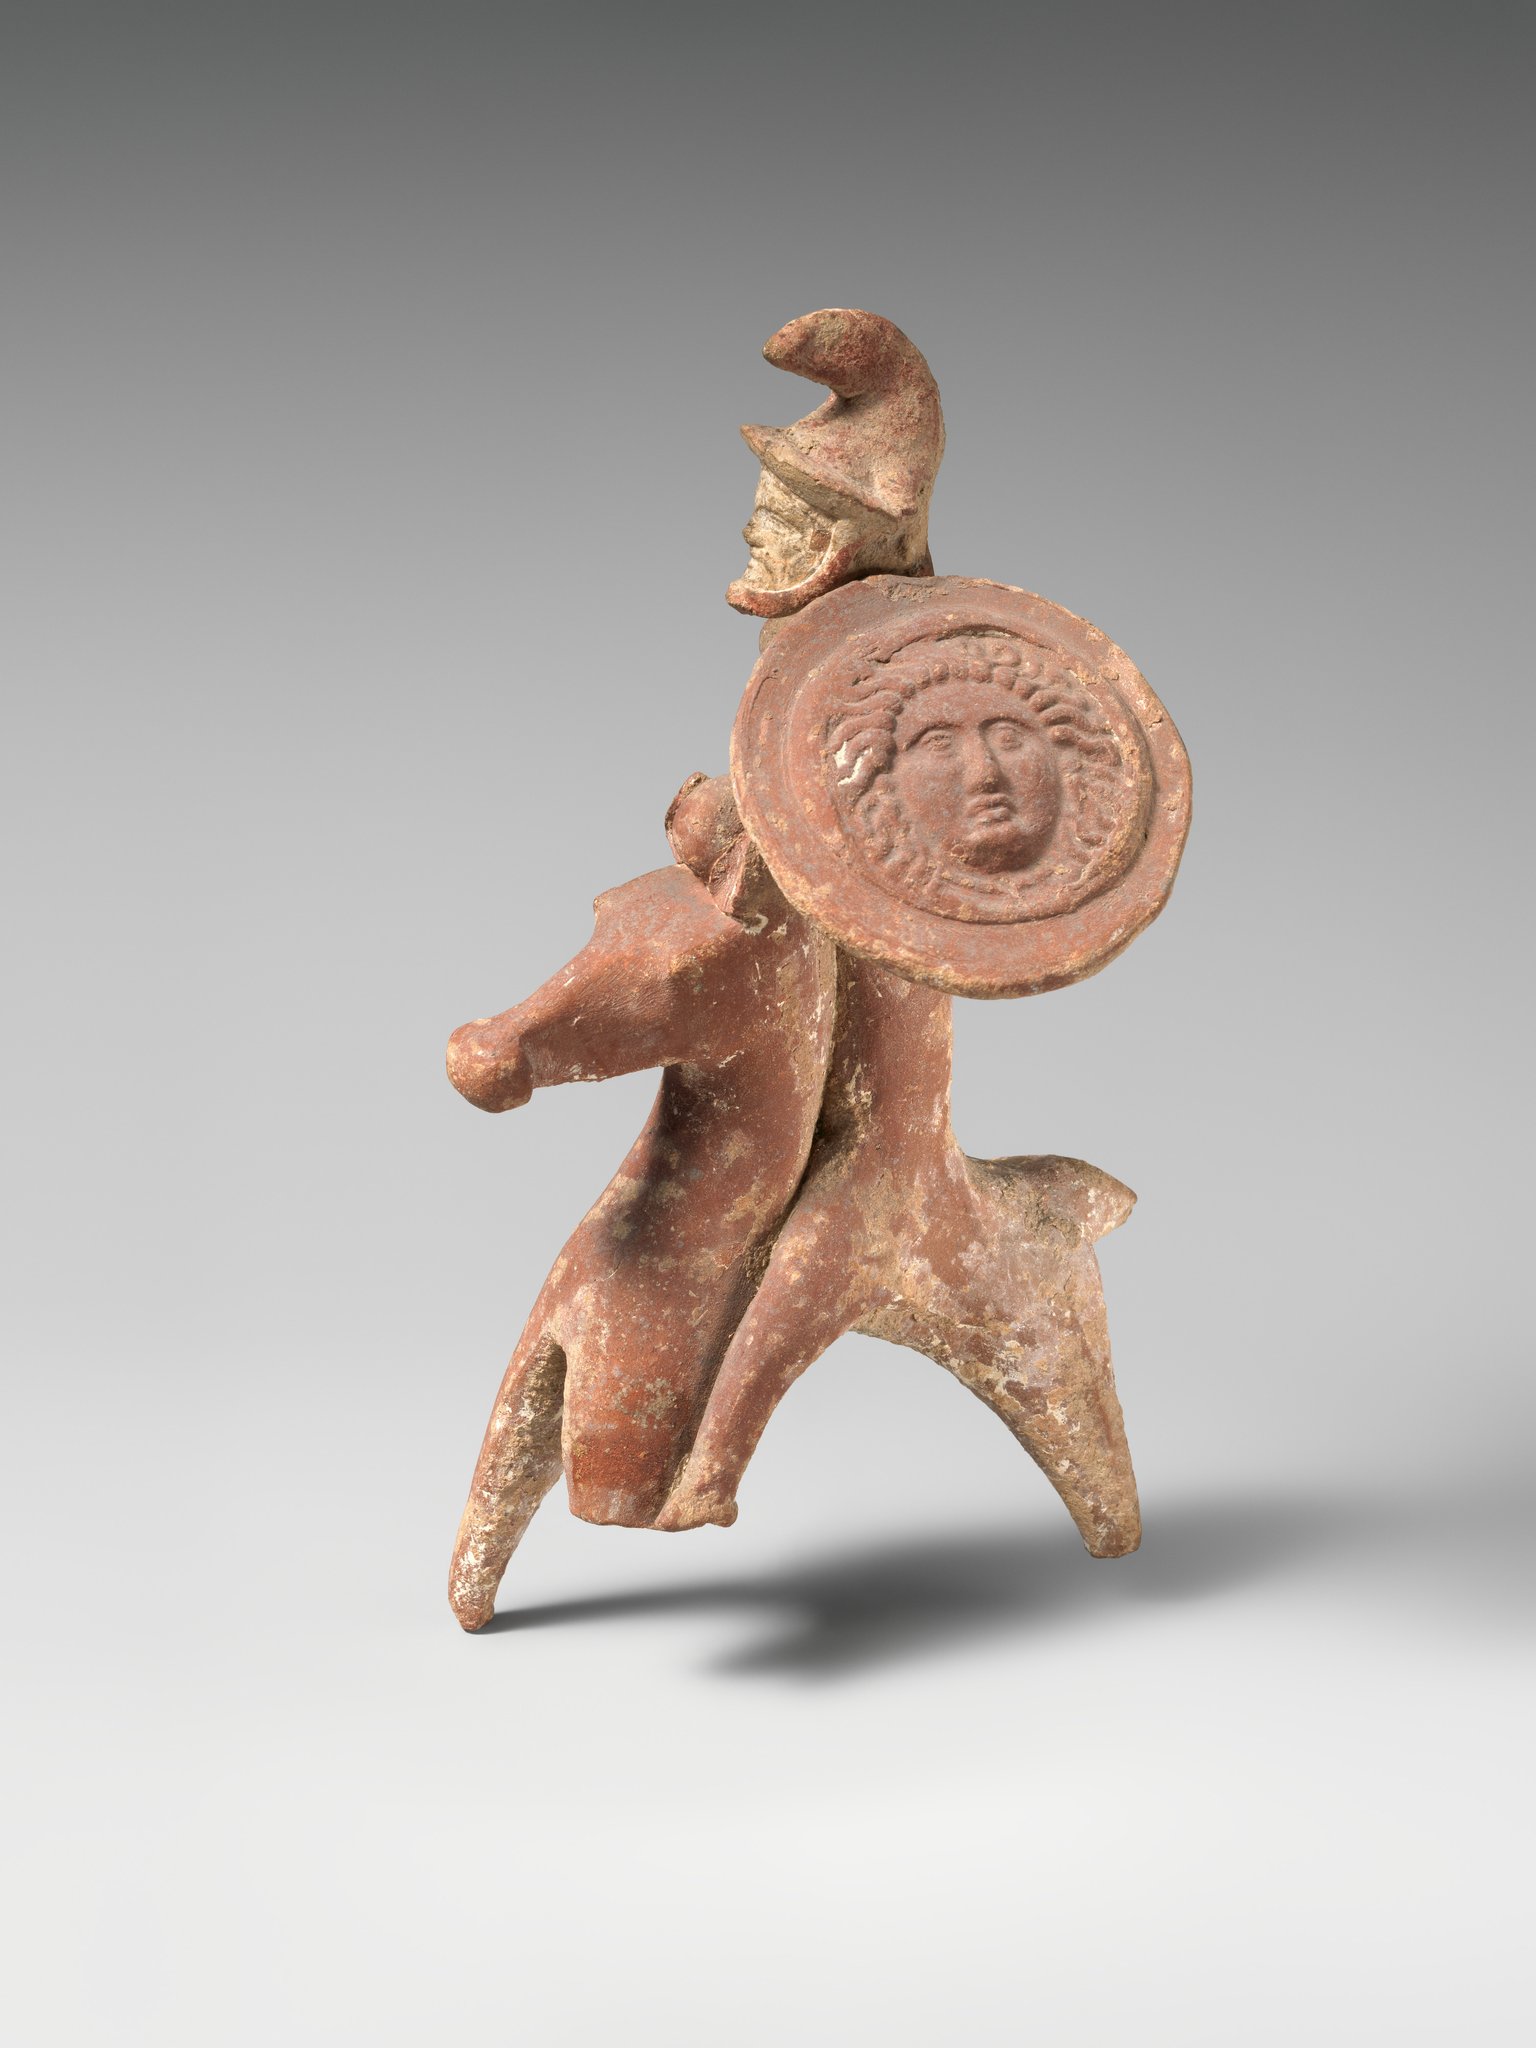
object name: statuette of a warrior on horse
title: Horse and rider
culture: cypriot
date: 300-268 BCE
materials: terracotta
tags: human figures,shields,faces,horses